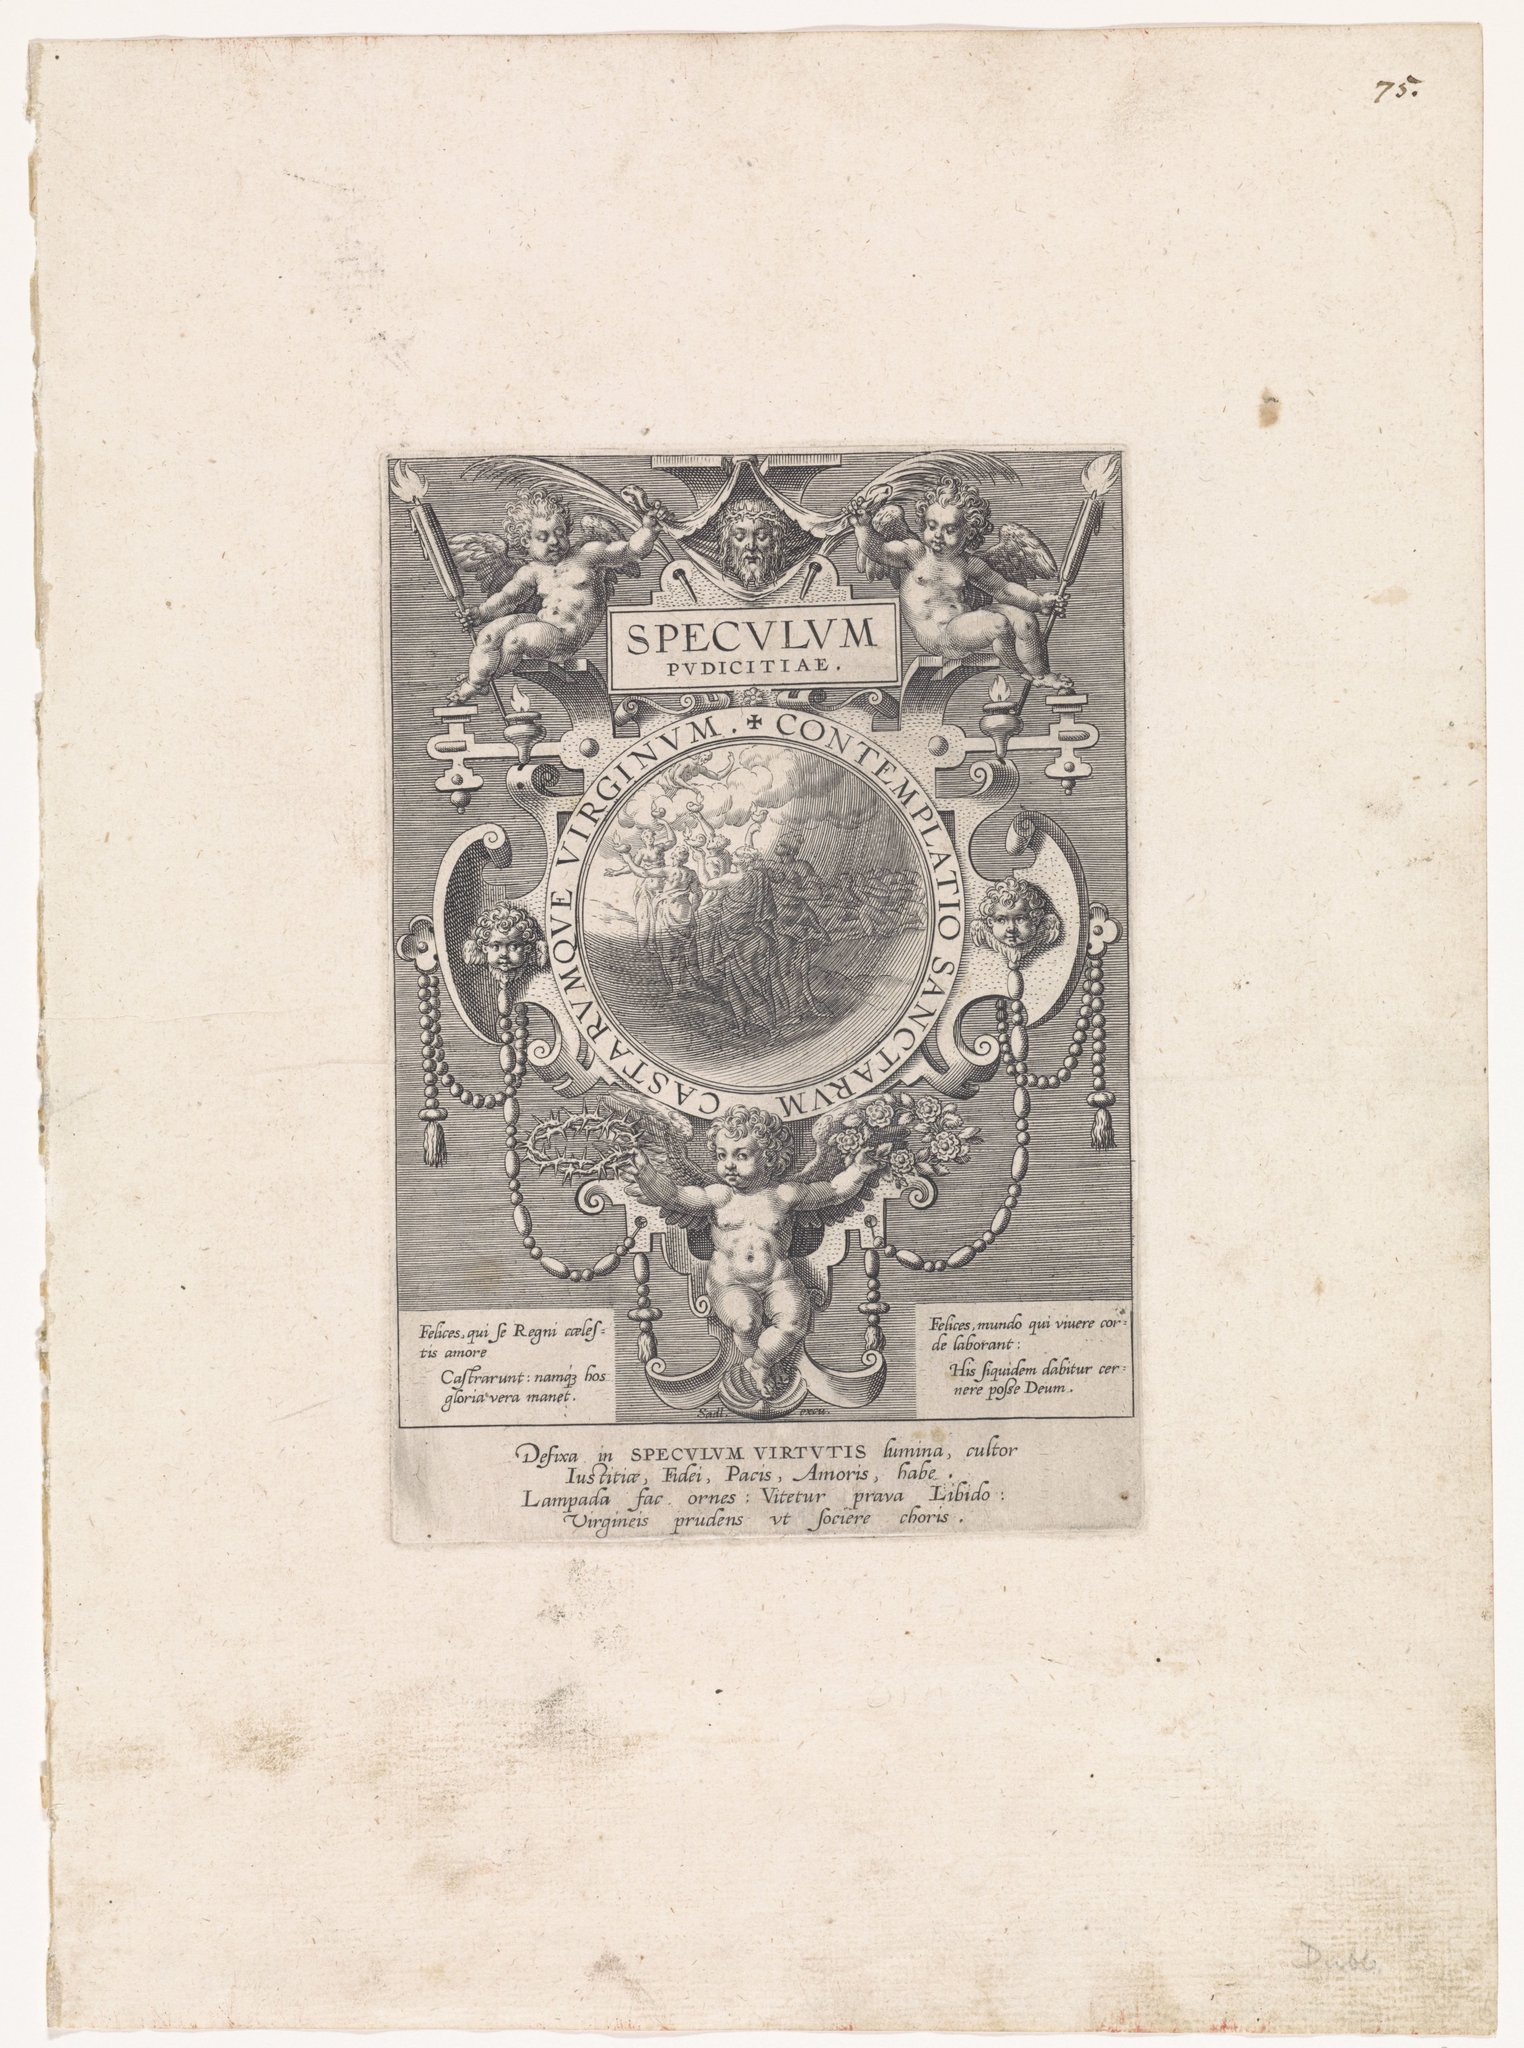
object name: titelprent, frontispice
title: Speculum Pudicitiae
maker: sadeler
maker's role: publisher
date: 1583-1587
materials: paper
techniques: engraving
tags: mirror, ornament ~ medallion, title-page, angels, 'vera icon', 'sudarium', veronica-portrait, non-narrative representations of the wise and the foolish virgins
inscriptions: collector's mark: Lugt 2228, number: ‘75’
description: Een ornamentele spiegel waarin de vijf wijze en de vijf dwaze maagden worden afgebeeld. De vijf wijze maagden houden hun olielampen omhoog richting de hemel waar Christus is verschenen, terwijl de dwaze maagden liggen te slapen. In de ornamentale omlijsting boven de spiegel houden twee engeltjes de Vera Icon omhoog. Onderaan een engeltje met een doornenkrans en een rozenkrans.